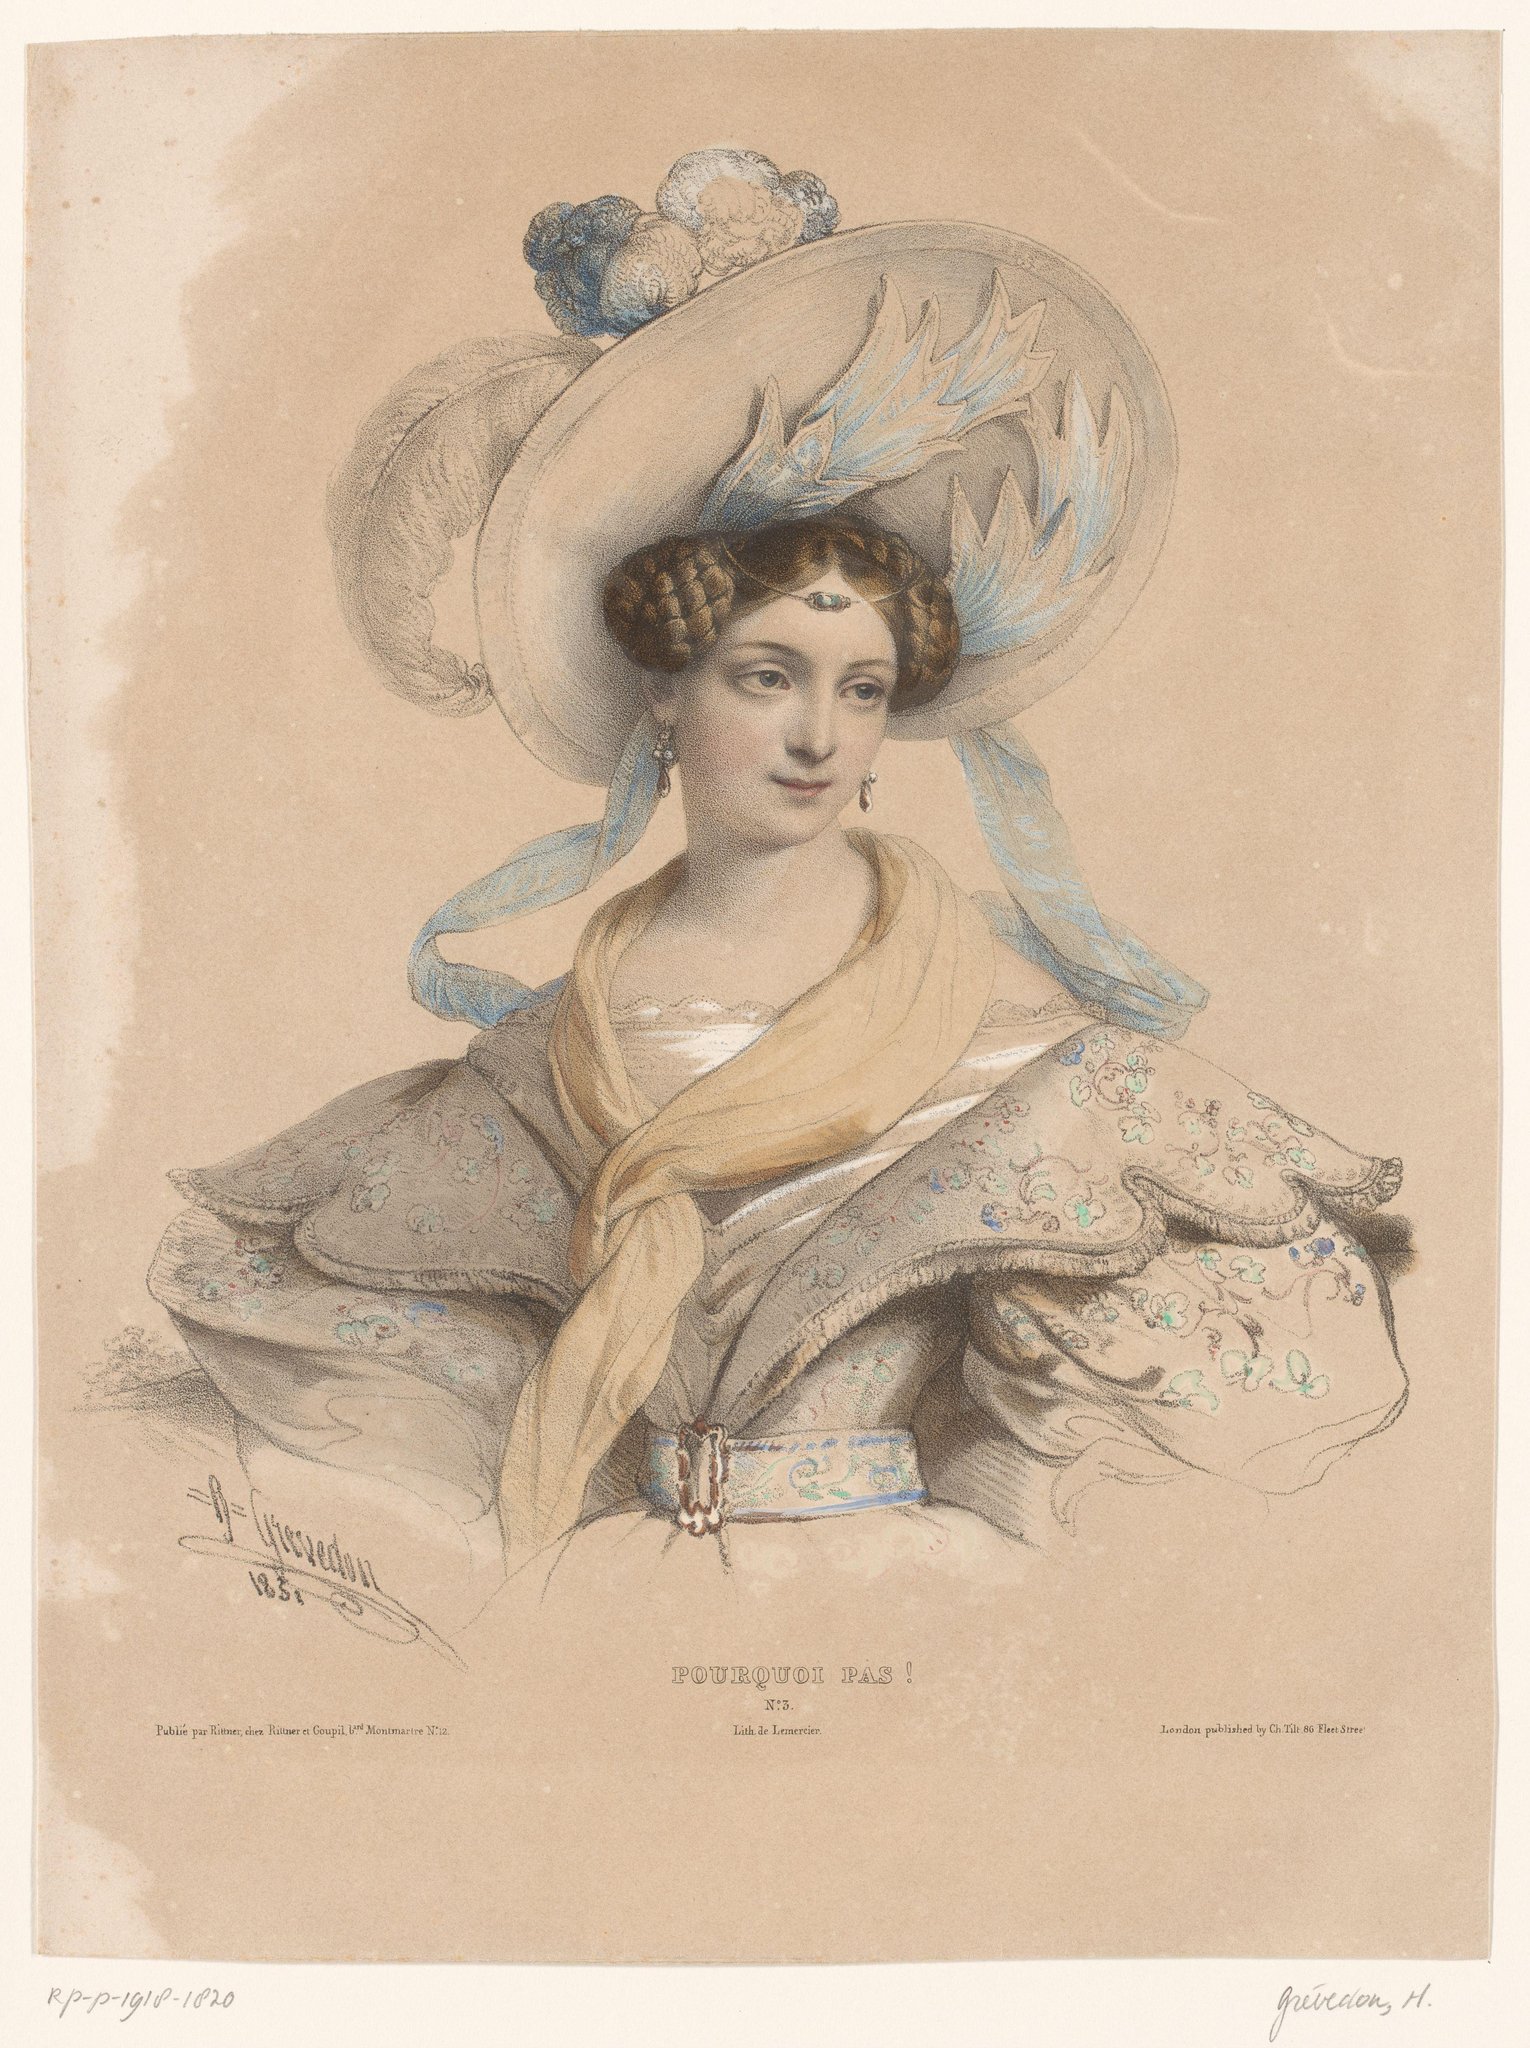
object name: print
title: Voorstellingen van in gedachten verzonken figuren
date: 1831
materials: paper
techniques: hand coloring, lithograph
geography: paris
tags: adolescent, young woman, maiden, head-gear: hat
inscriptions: collector's mark: Lugt 2233